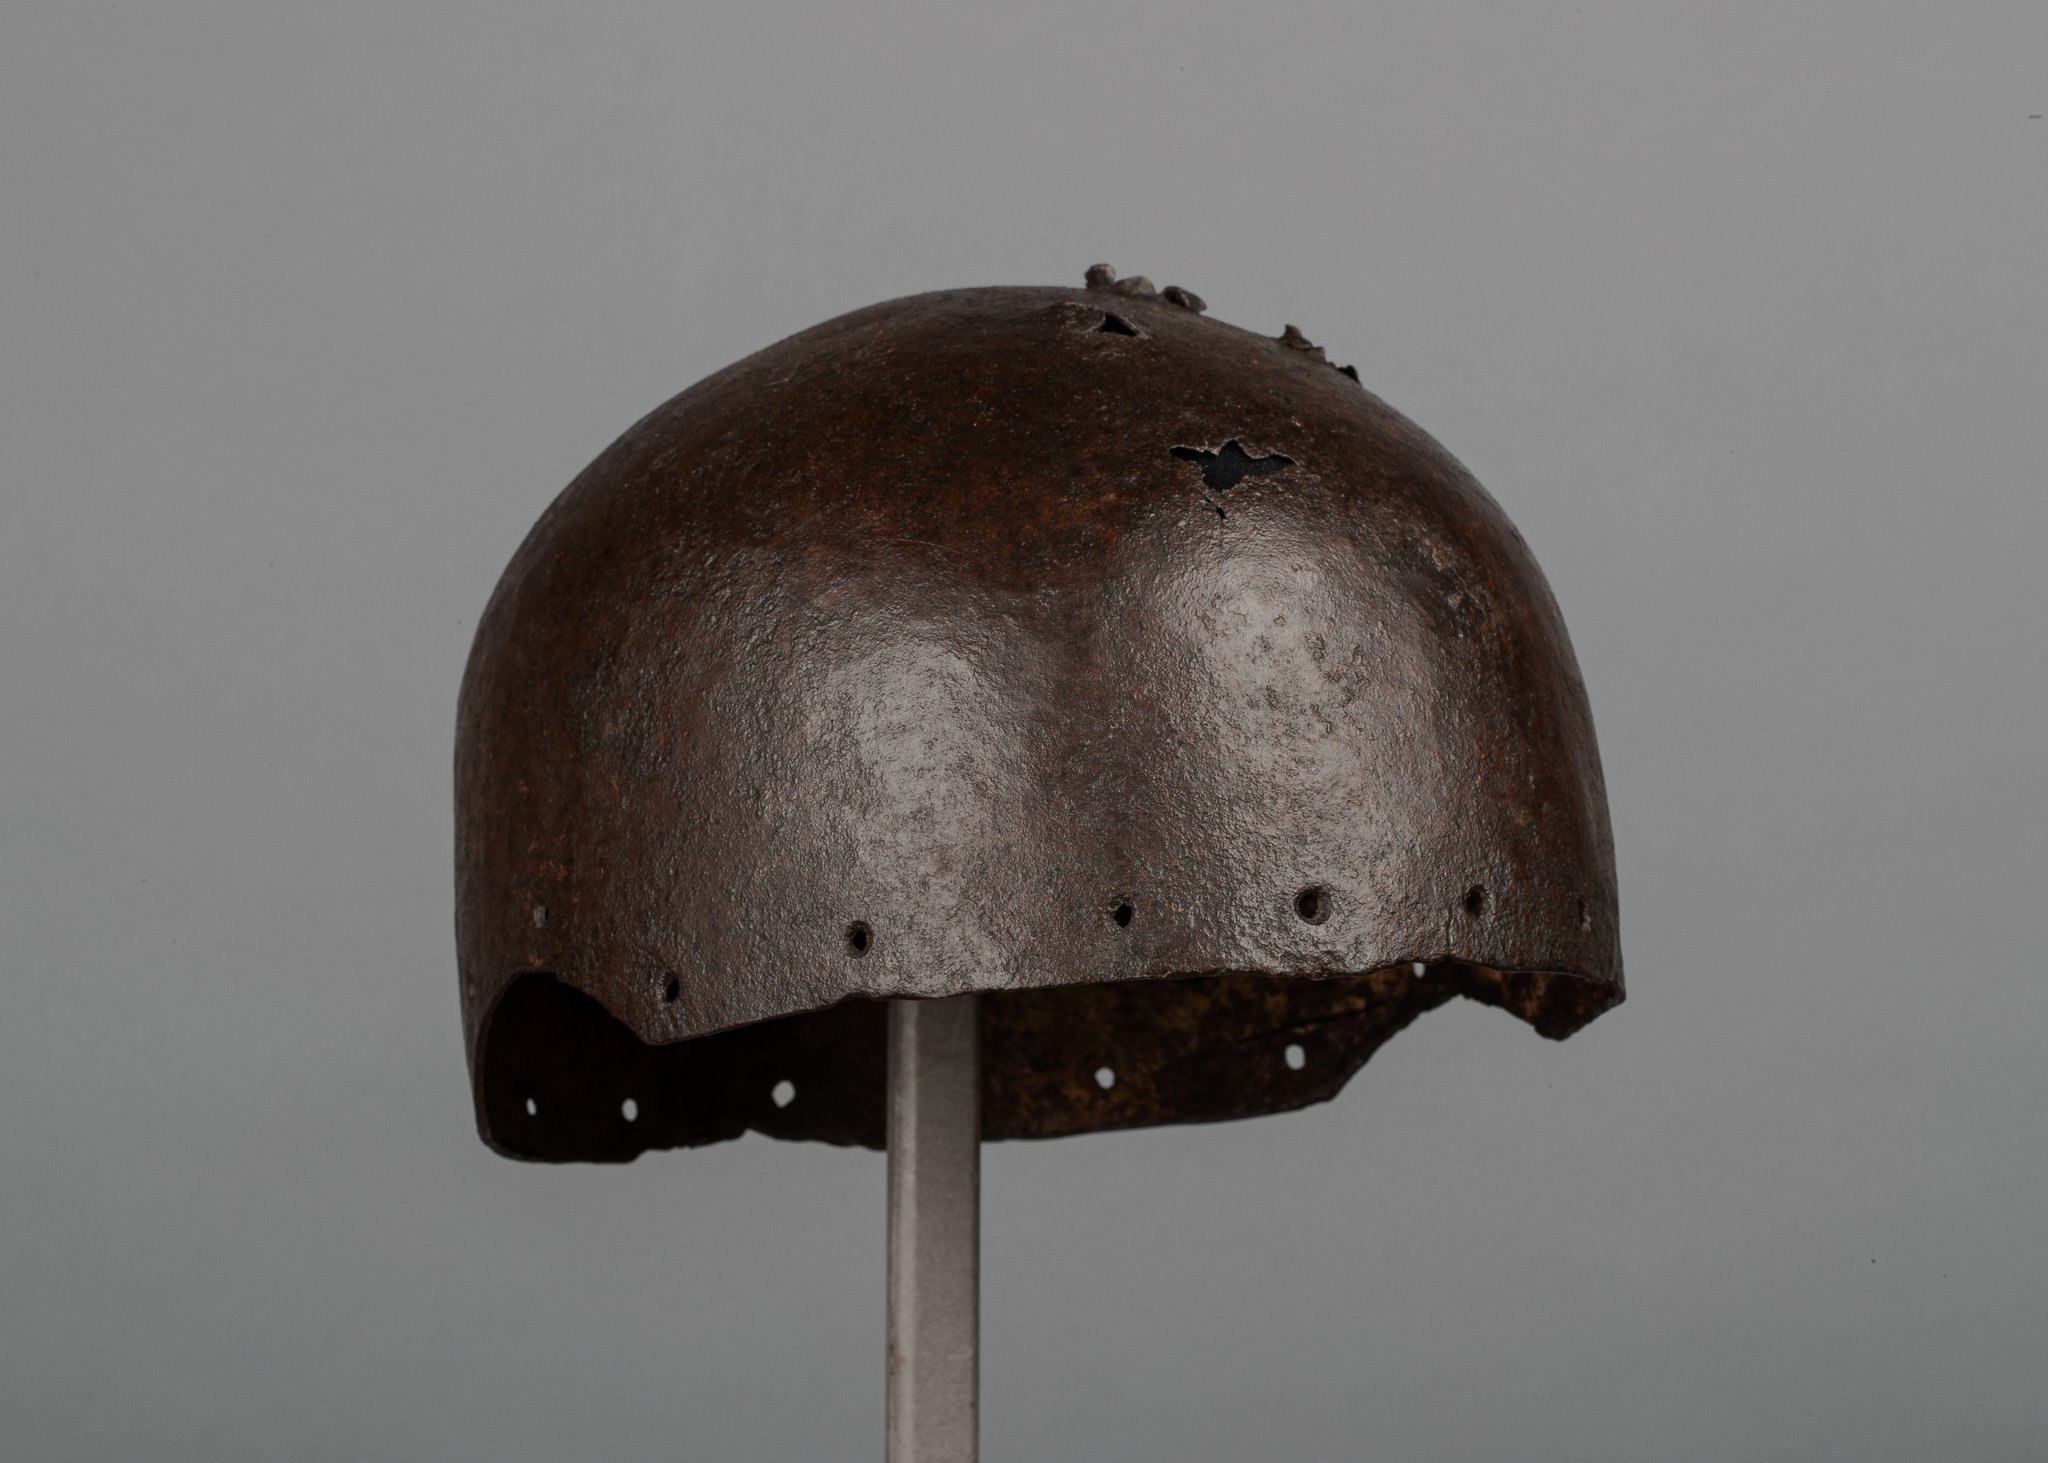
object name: helmet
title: Small Sallet (Celatina)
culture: italian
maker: missaglia workshop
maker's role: armorer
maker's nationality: italian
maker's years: 1430-1529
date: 1450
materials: steel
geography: italy